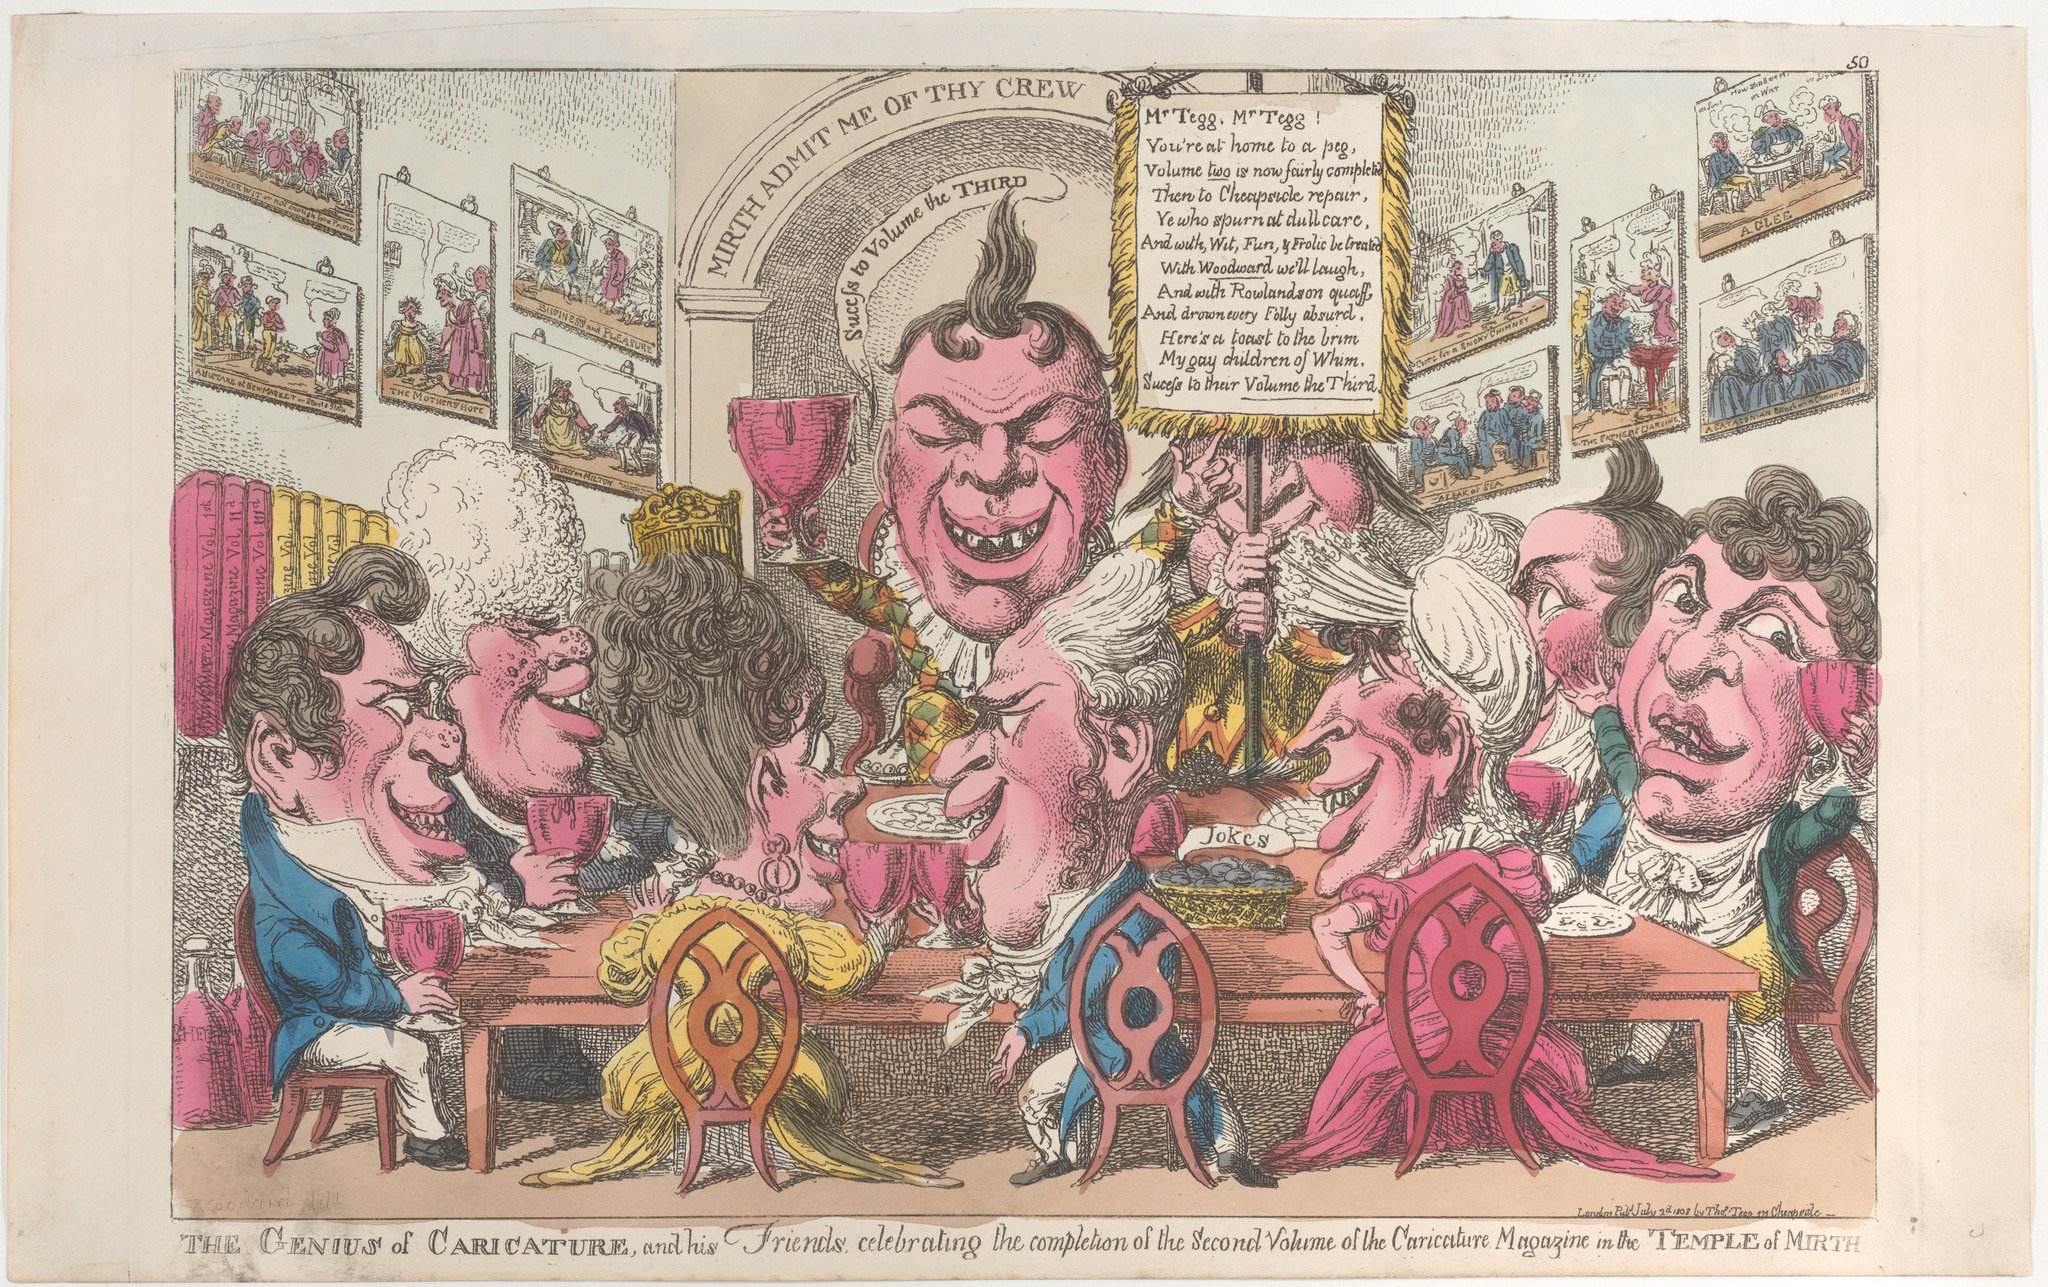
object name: print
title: The Genius of Caricature, and his Friends, celebrating the completion of the Second Volume of the Caricature Magazine in the Temple of Mirth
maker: george murgatroyd woodward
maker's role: artist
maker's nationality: british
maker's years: 1765-1809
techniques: etching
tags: men,women,dining,drinking,caricature